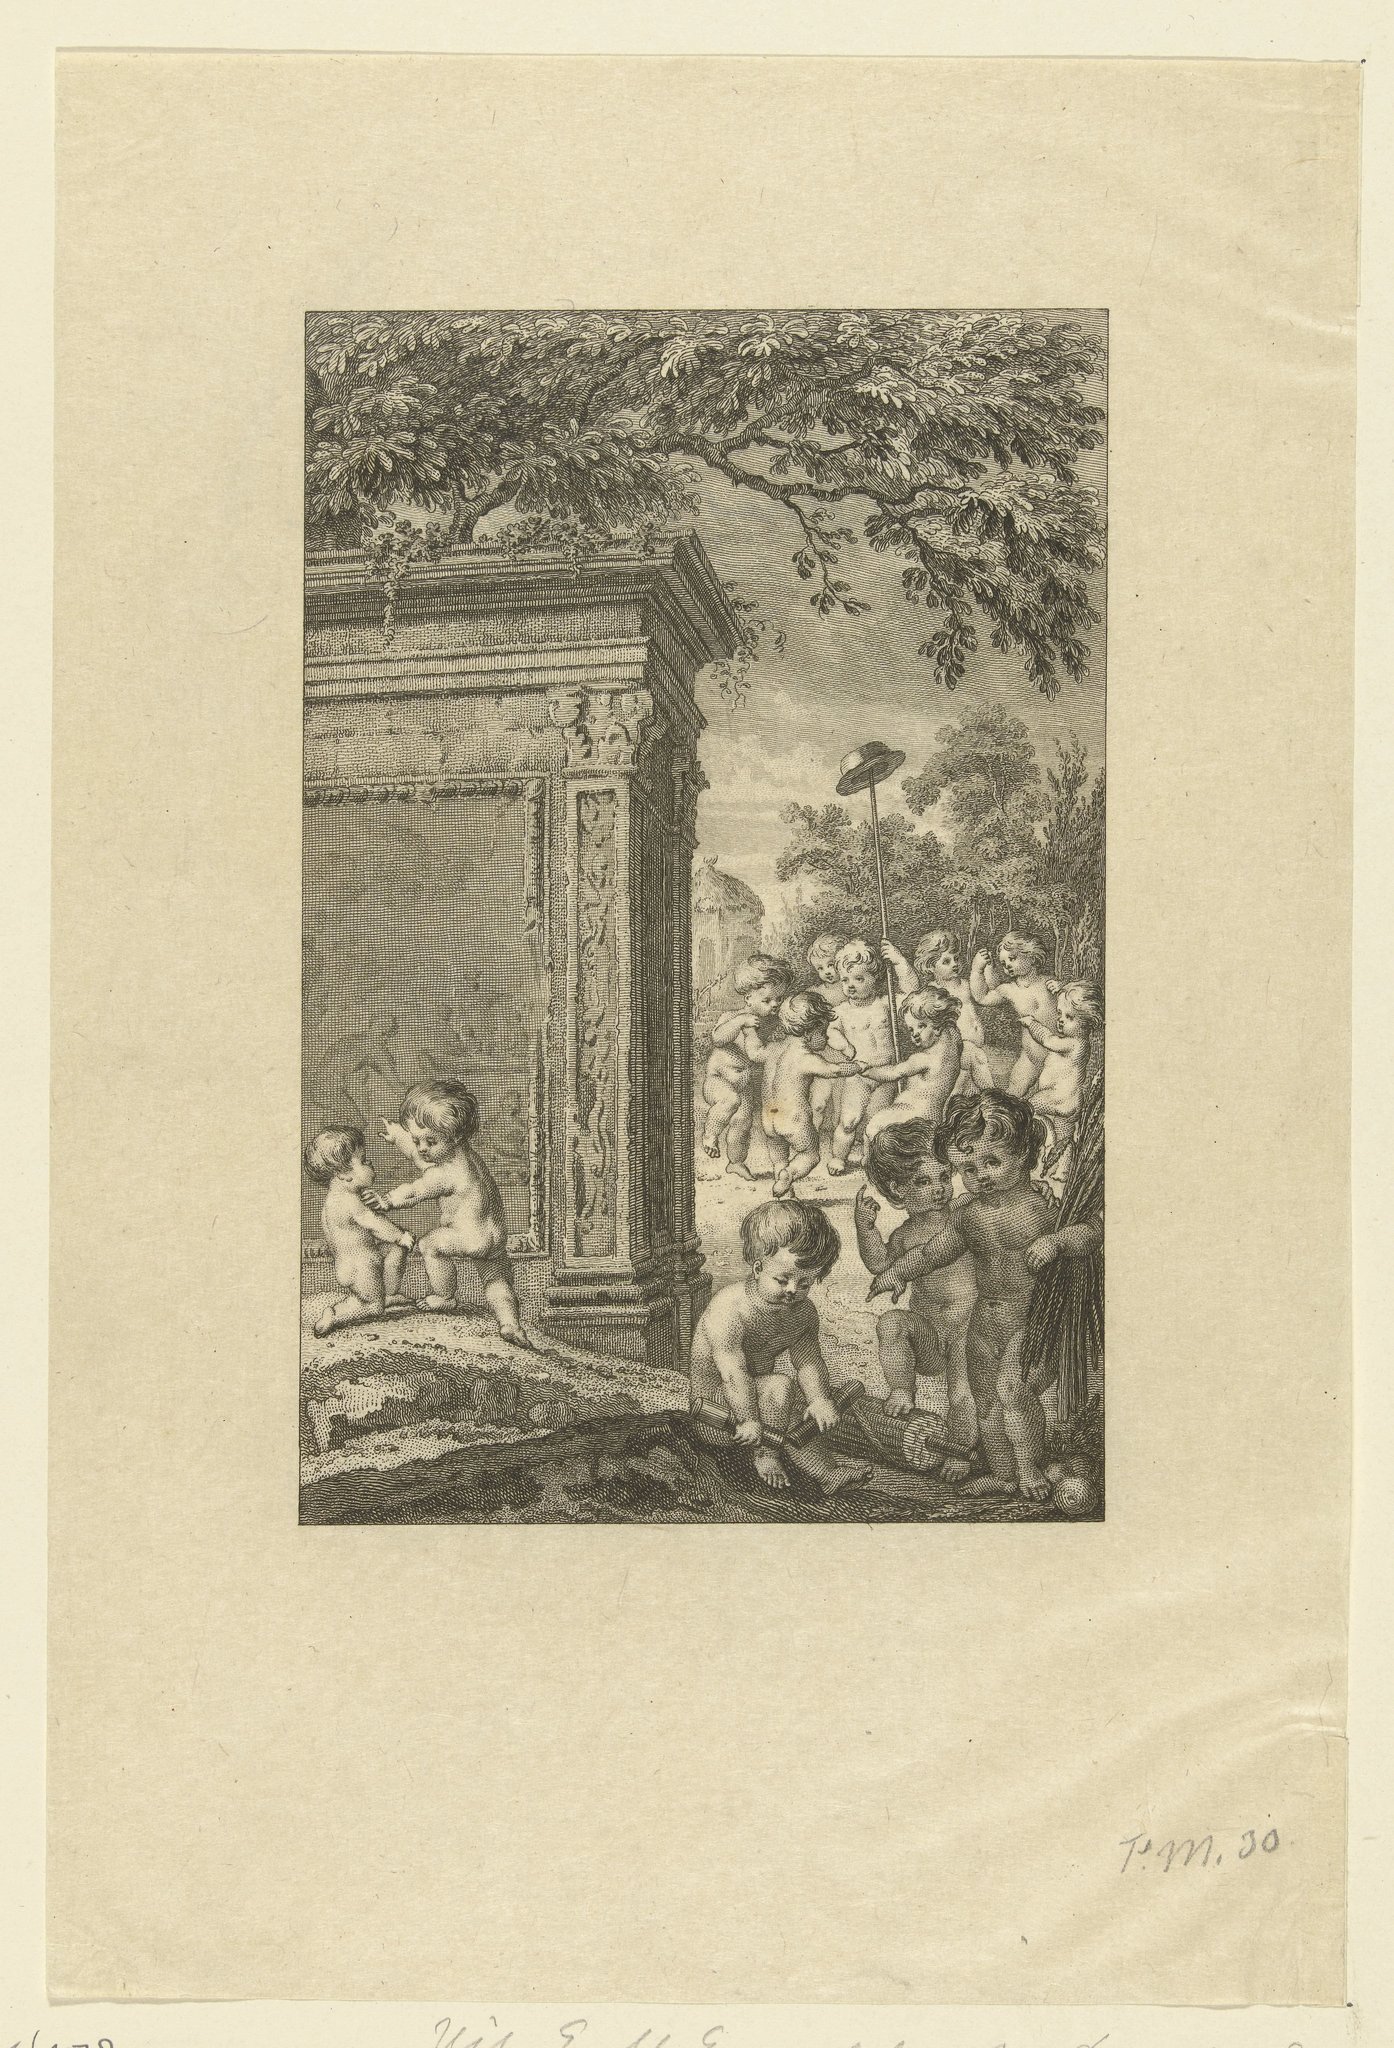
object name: titelblad, titelpagina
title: Ontwerp voor titelblad voor: Aloude Staat der Verenigde Nederlanden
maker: reinier vinkeles (i)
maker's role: draughtsman, print maker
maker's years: 1741-1816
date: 1782-1784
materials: paper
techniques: etching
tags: symbols of particular nations, states, districts, etc., netherlands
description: Ontwerp voor titelblad voor: Aloude Staat der Verenigde Nederlanden. Spelende putti bij een ruïne en dansend rond de vrijheidshoed op een stok.